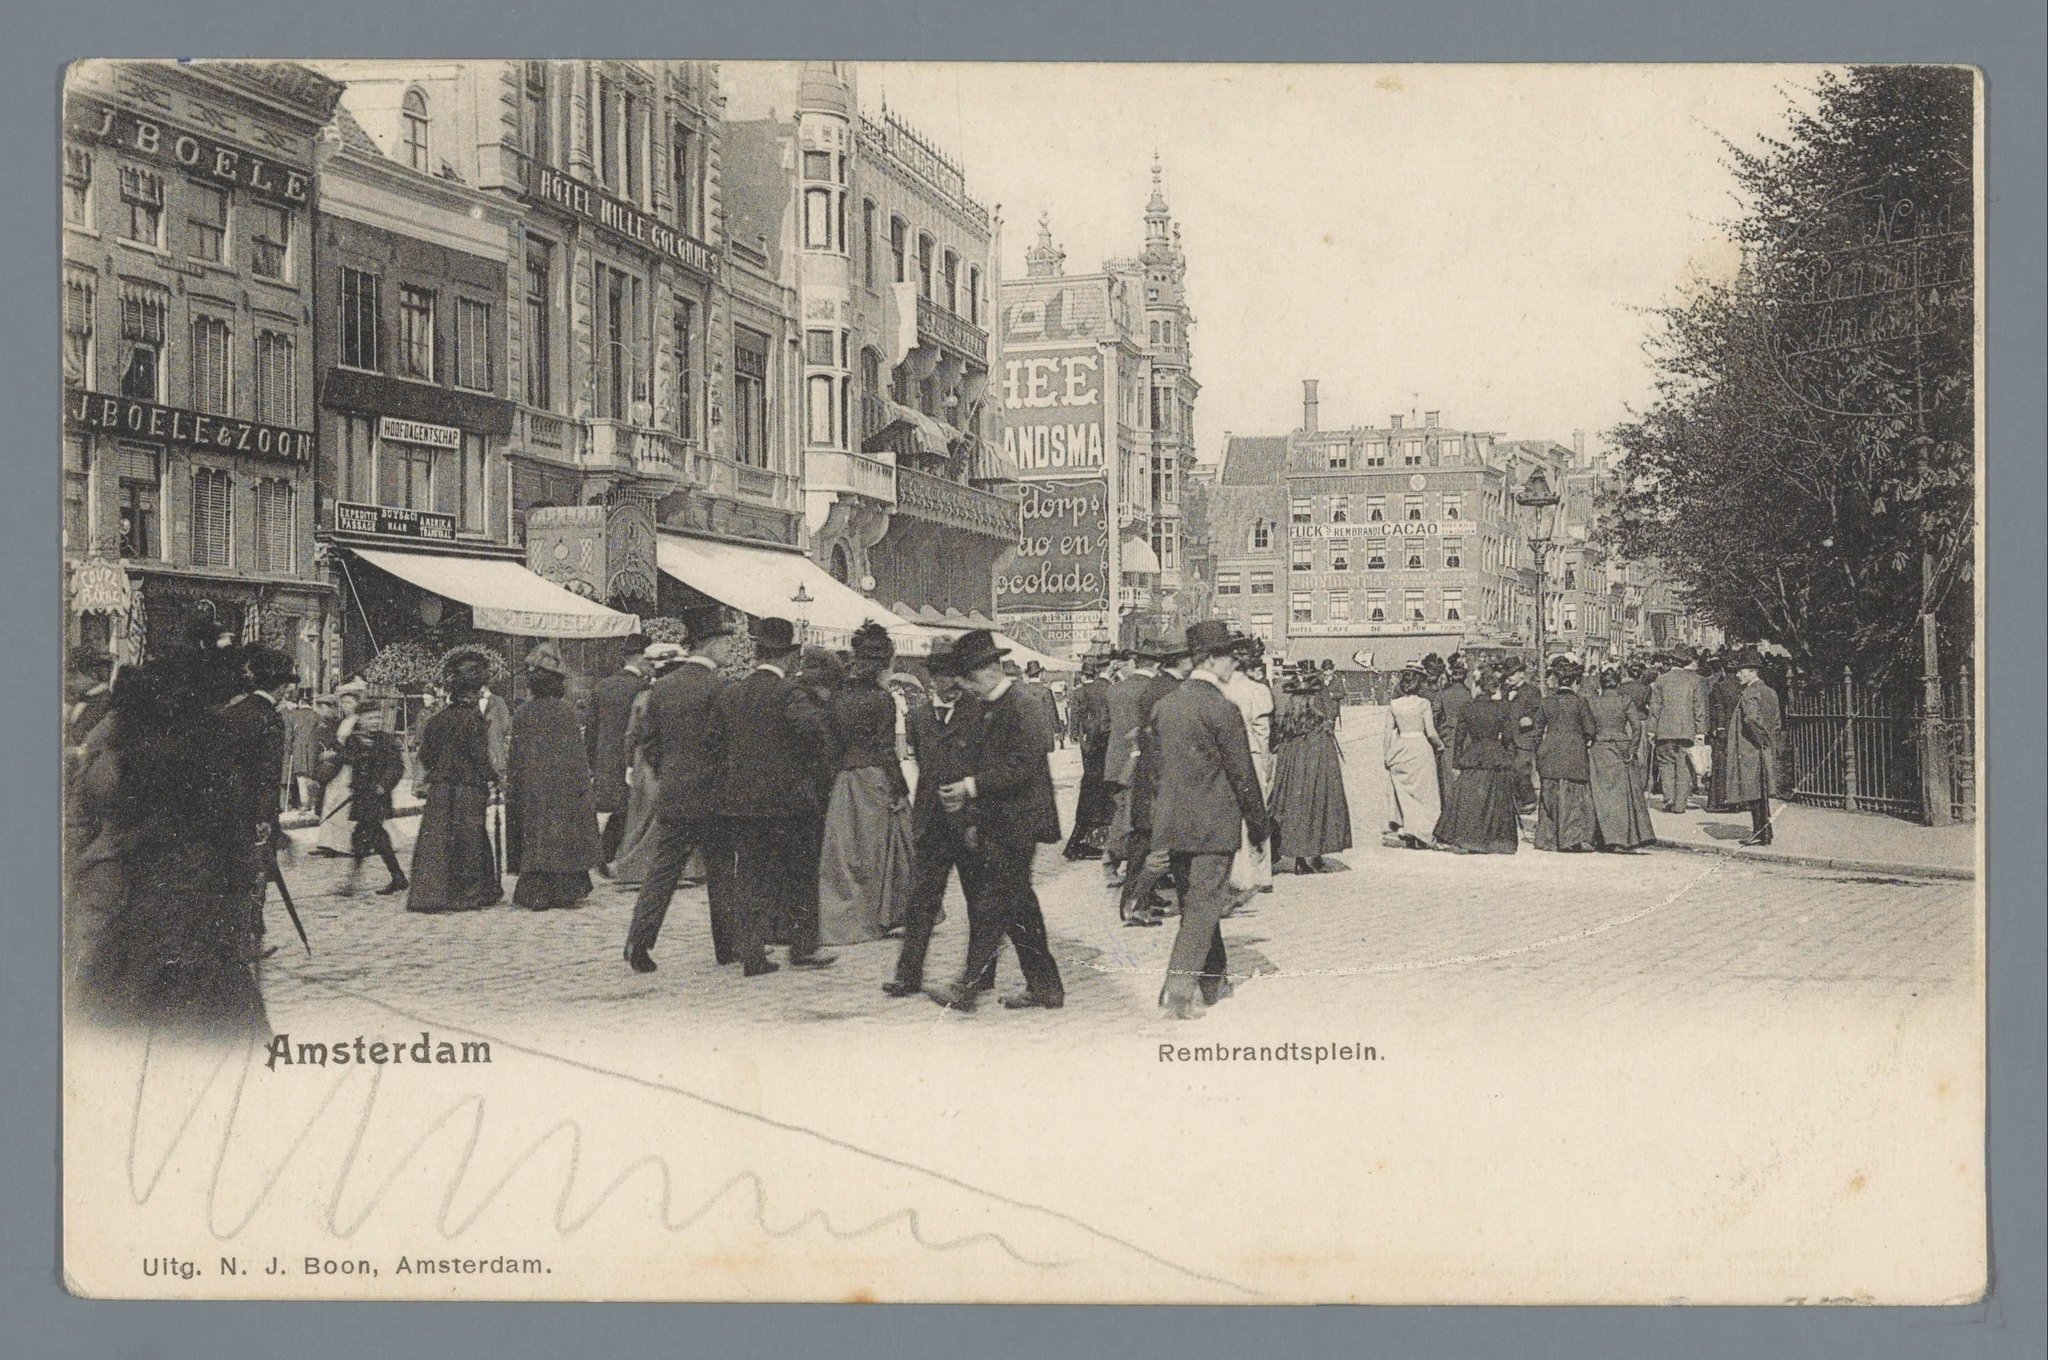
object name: ansichtkaart, prentbriefkaart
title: Amsterdam, Rembrandtsplein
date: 1875-1930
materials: cardboard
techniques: photograph, writing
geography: amsterdam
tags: square, place, circus, etc.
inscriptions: retailer's mark: ‘L. Beets/ Lauriergracht 52II/ Amsterdam-C.’